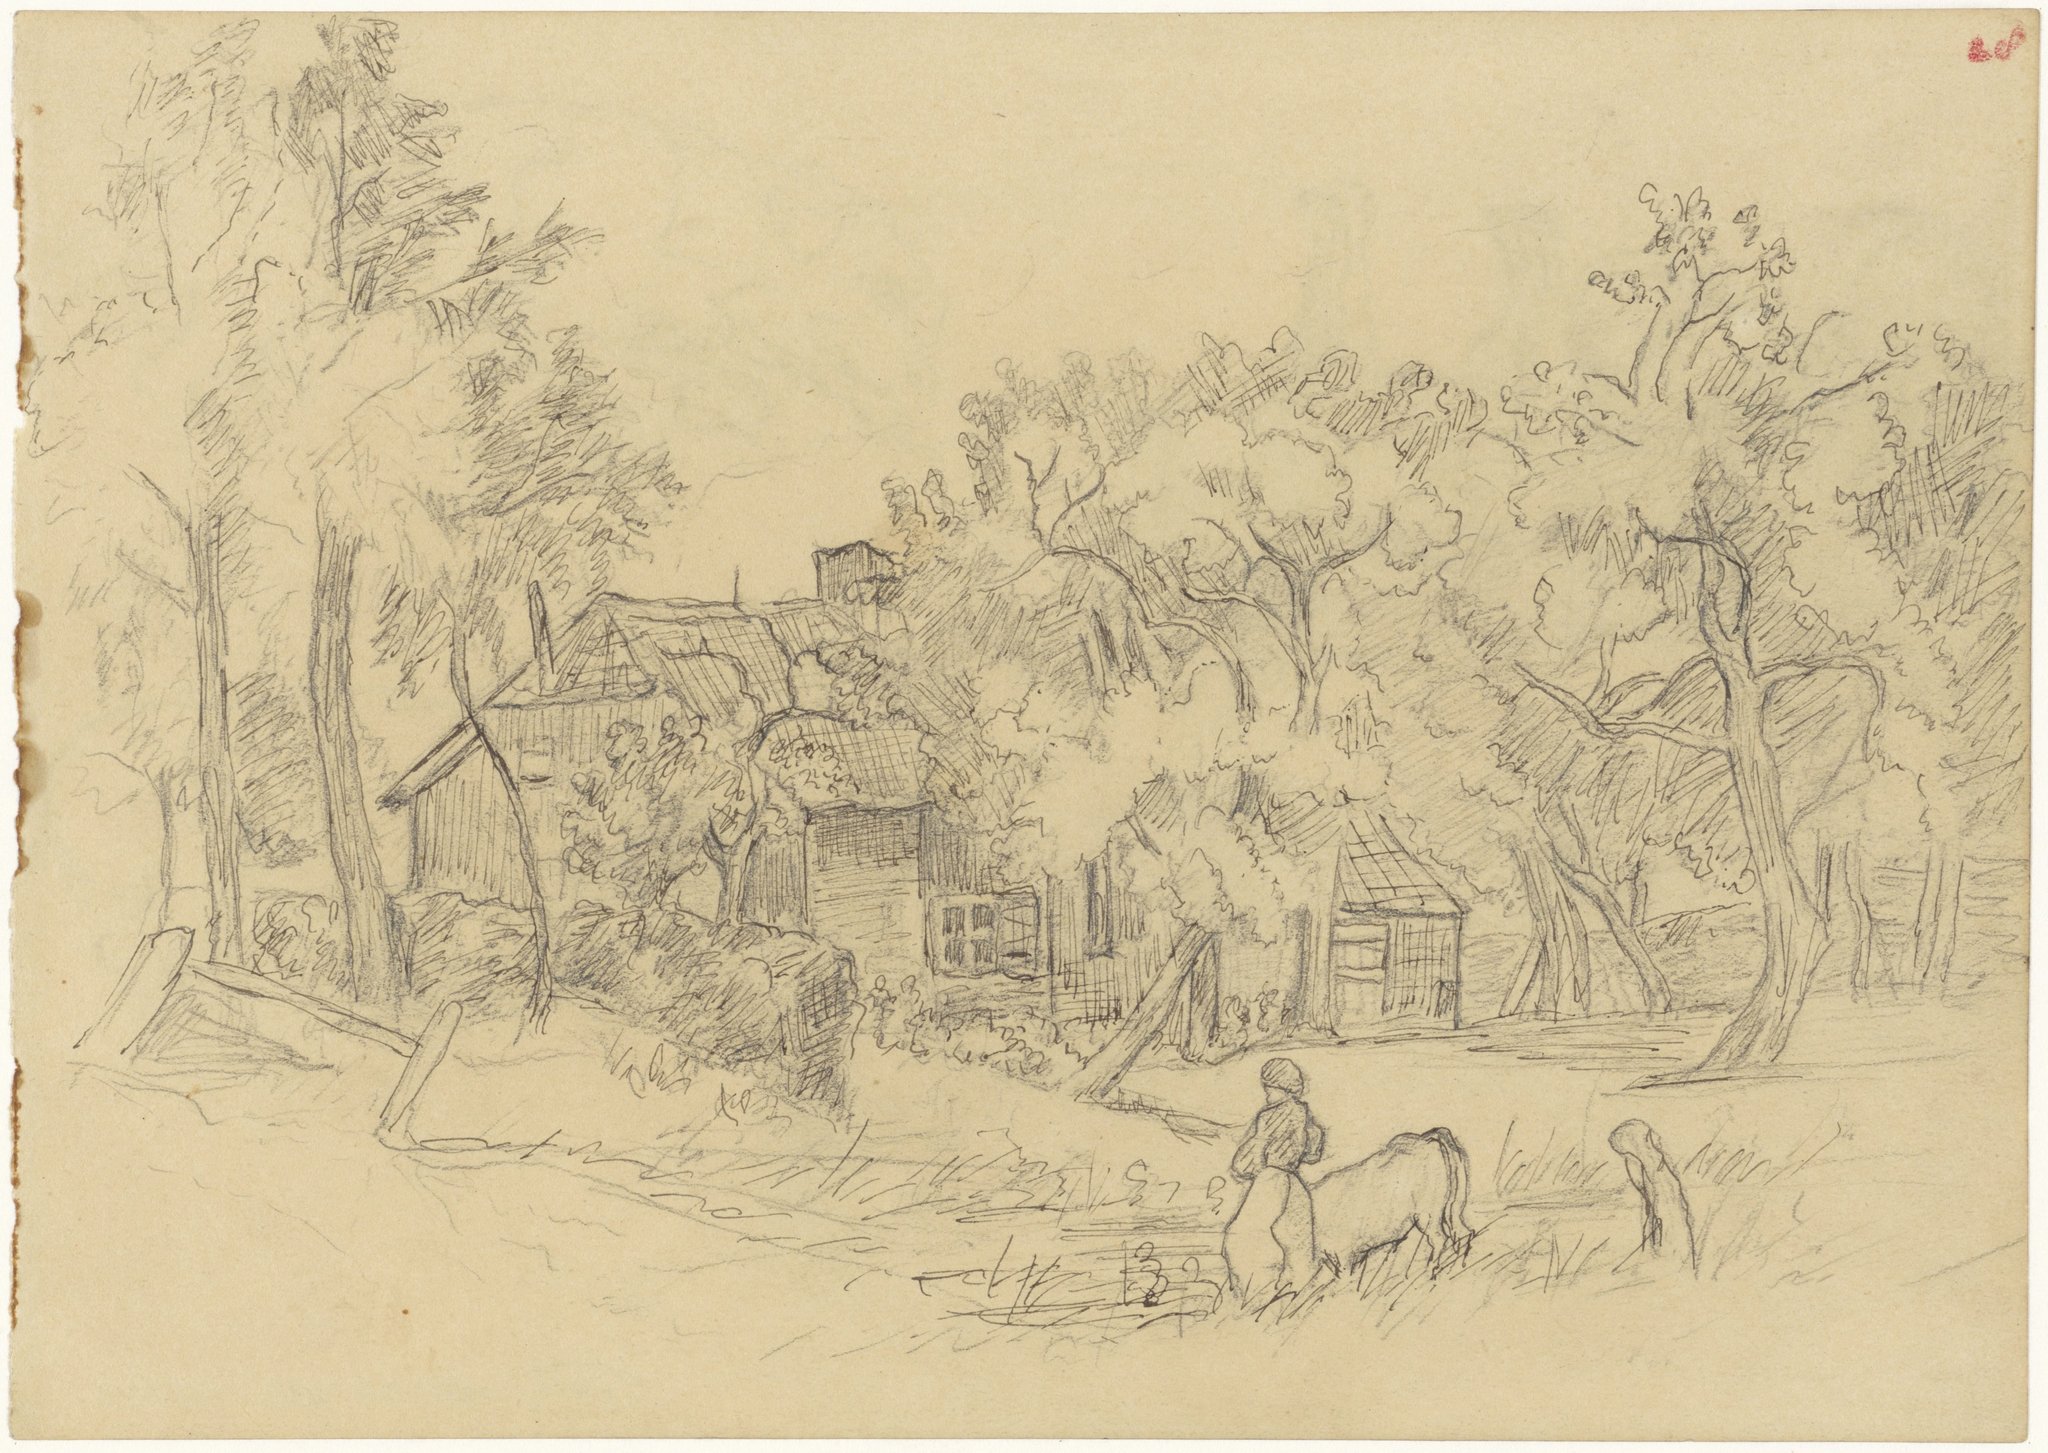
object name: drawing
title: Boerderij tussen bomen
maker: jozef israëls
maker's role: draughtsman, painter, print maker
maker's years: 1824-1911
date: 1834-1911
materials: ink, paper, pencil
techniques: pen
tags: farm (building)